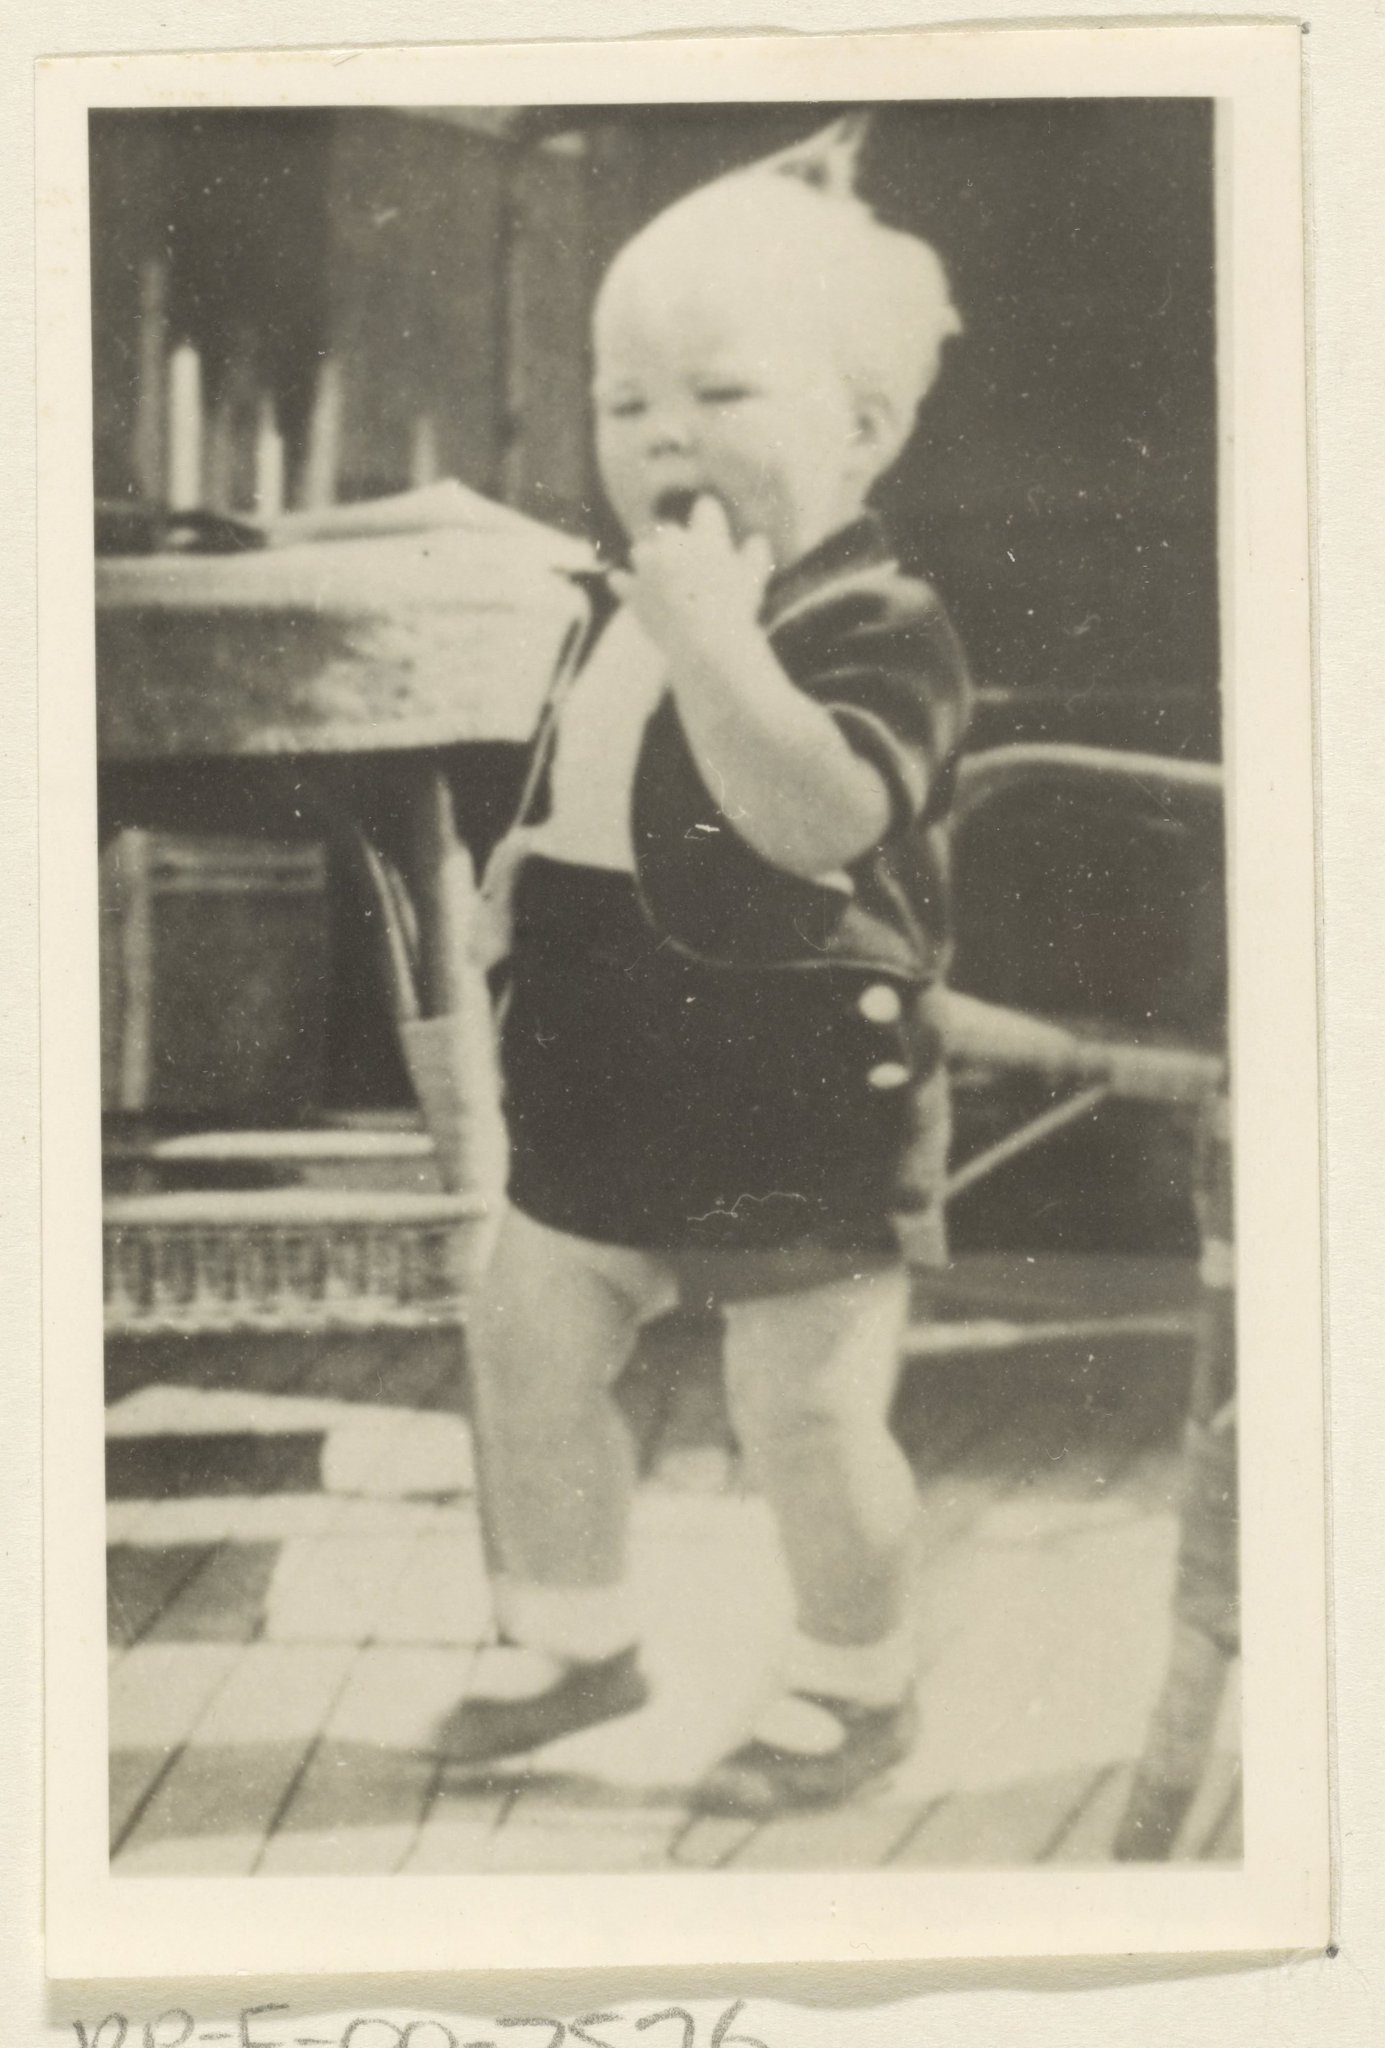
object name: photograph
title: Portret van Beatrix, koningin der Nederlanden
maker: Anonymous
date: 1939-1941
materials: photographic support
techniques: photography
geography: netherlands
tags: beatrix (koningin der nederlanden)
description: De hier vermelde titel verwijst naar de hoogst verkregen titel van de geportretteerde, niet per se naar de titel die de geportretteerde op deze voorstelling draagt.